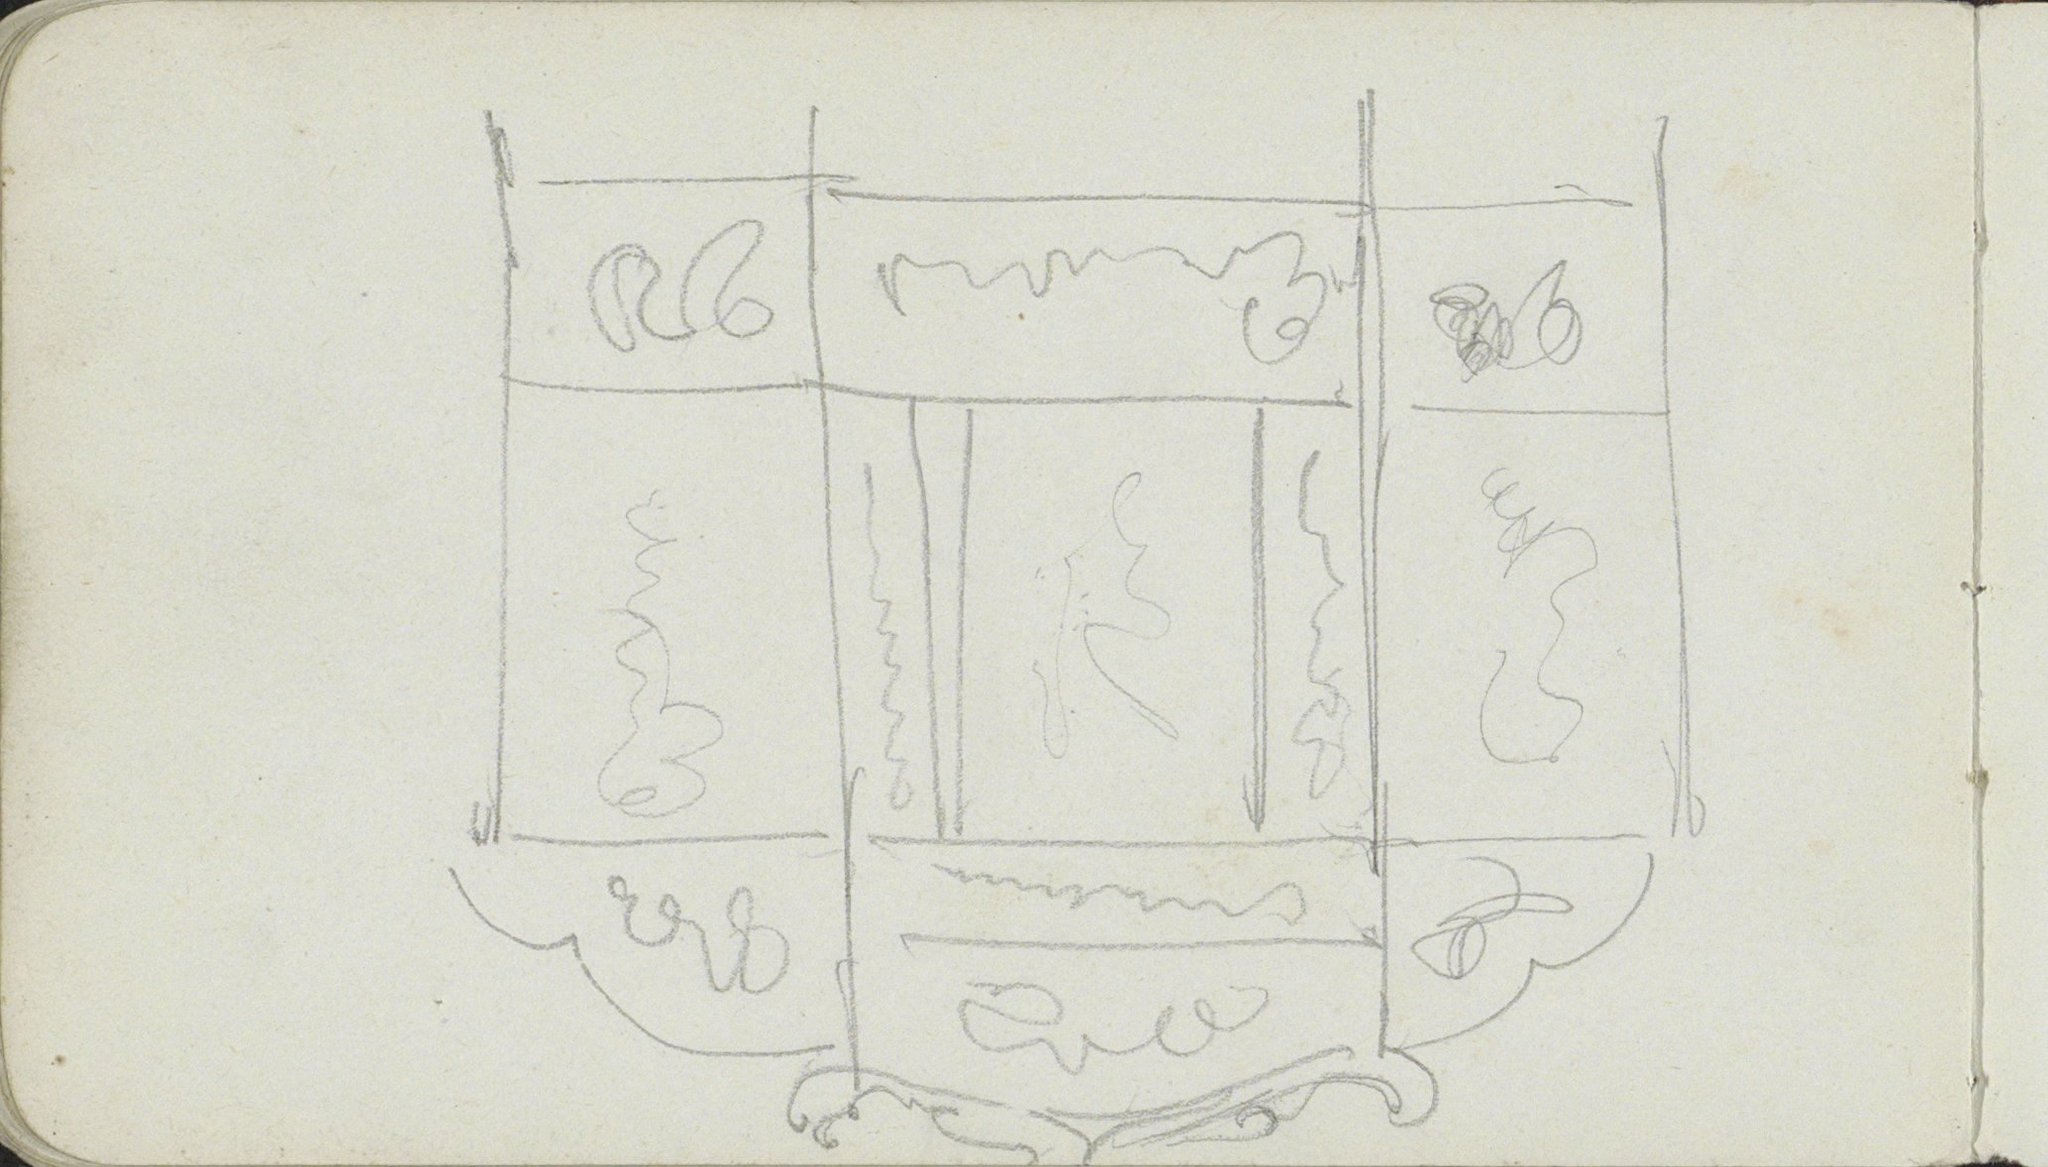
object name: sketchbook leaf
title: Meubelstuk, vermoedelijk een gedecoreerd scherm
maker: carel adolph lion cachet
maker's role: draughtsman, print maker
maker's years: 1864-1945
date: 1905-1906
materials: paper, pencil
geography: vreeland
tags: screen, folding screen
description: Blad 33 verso uit een schetsboek met 34 bladen.